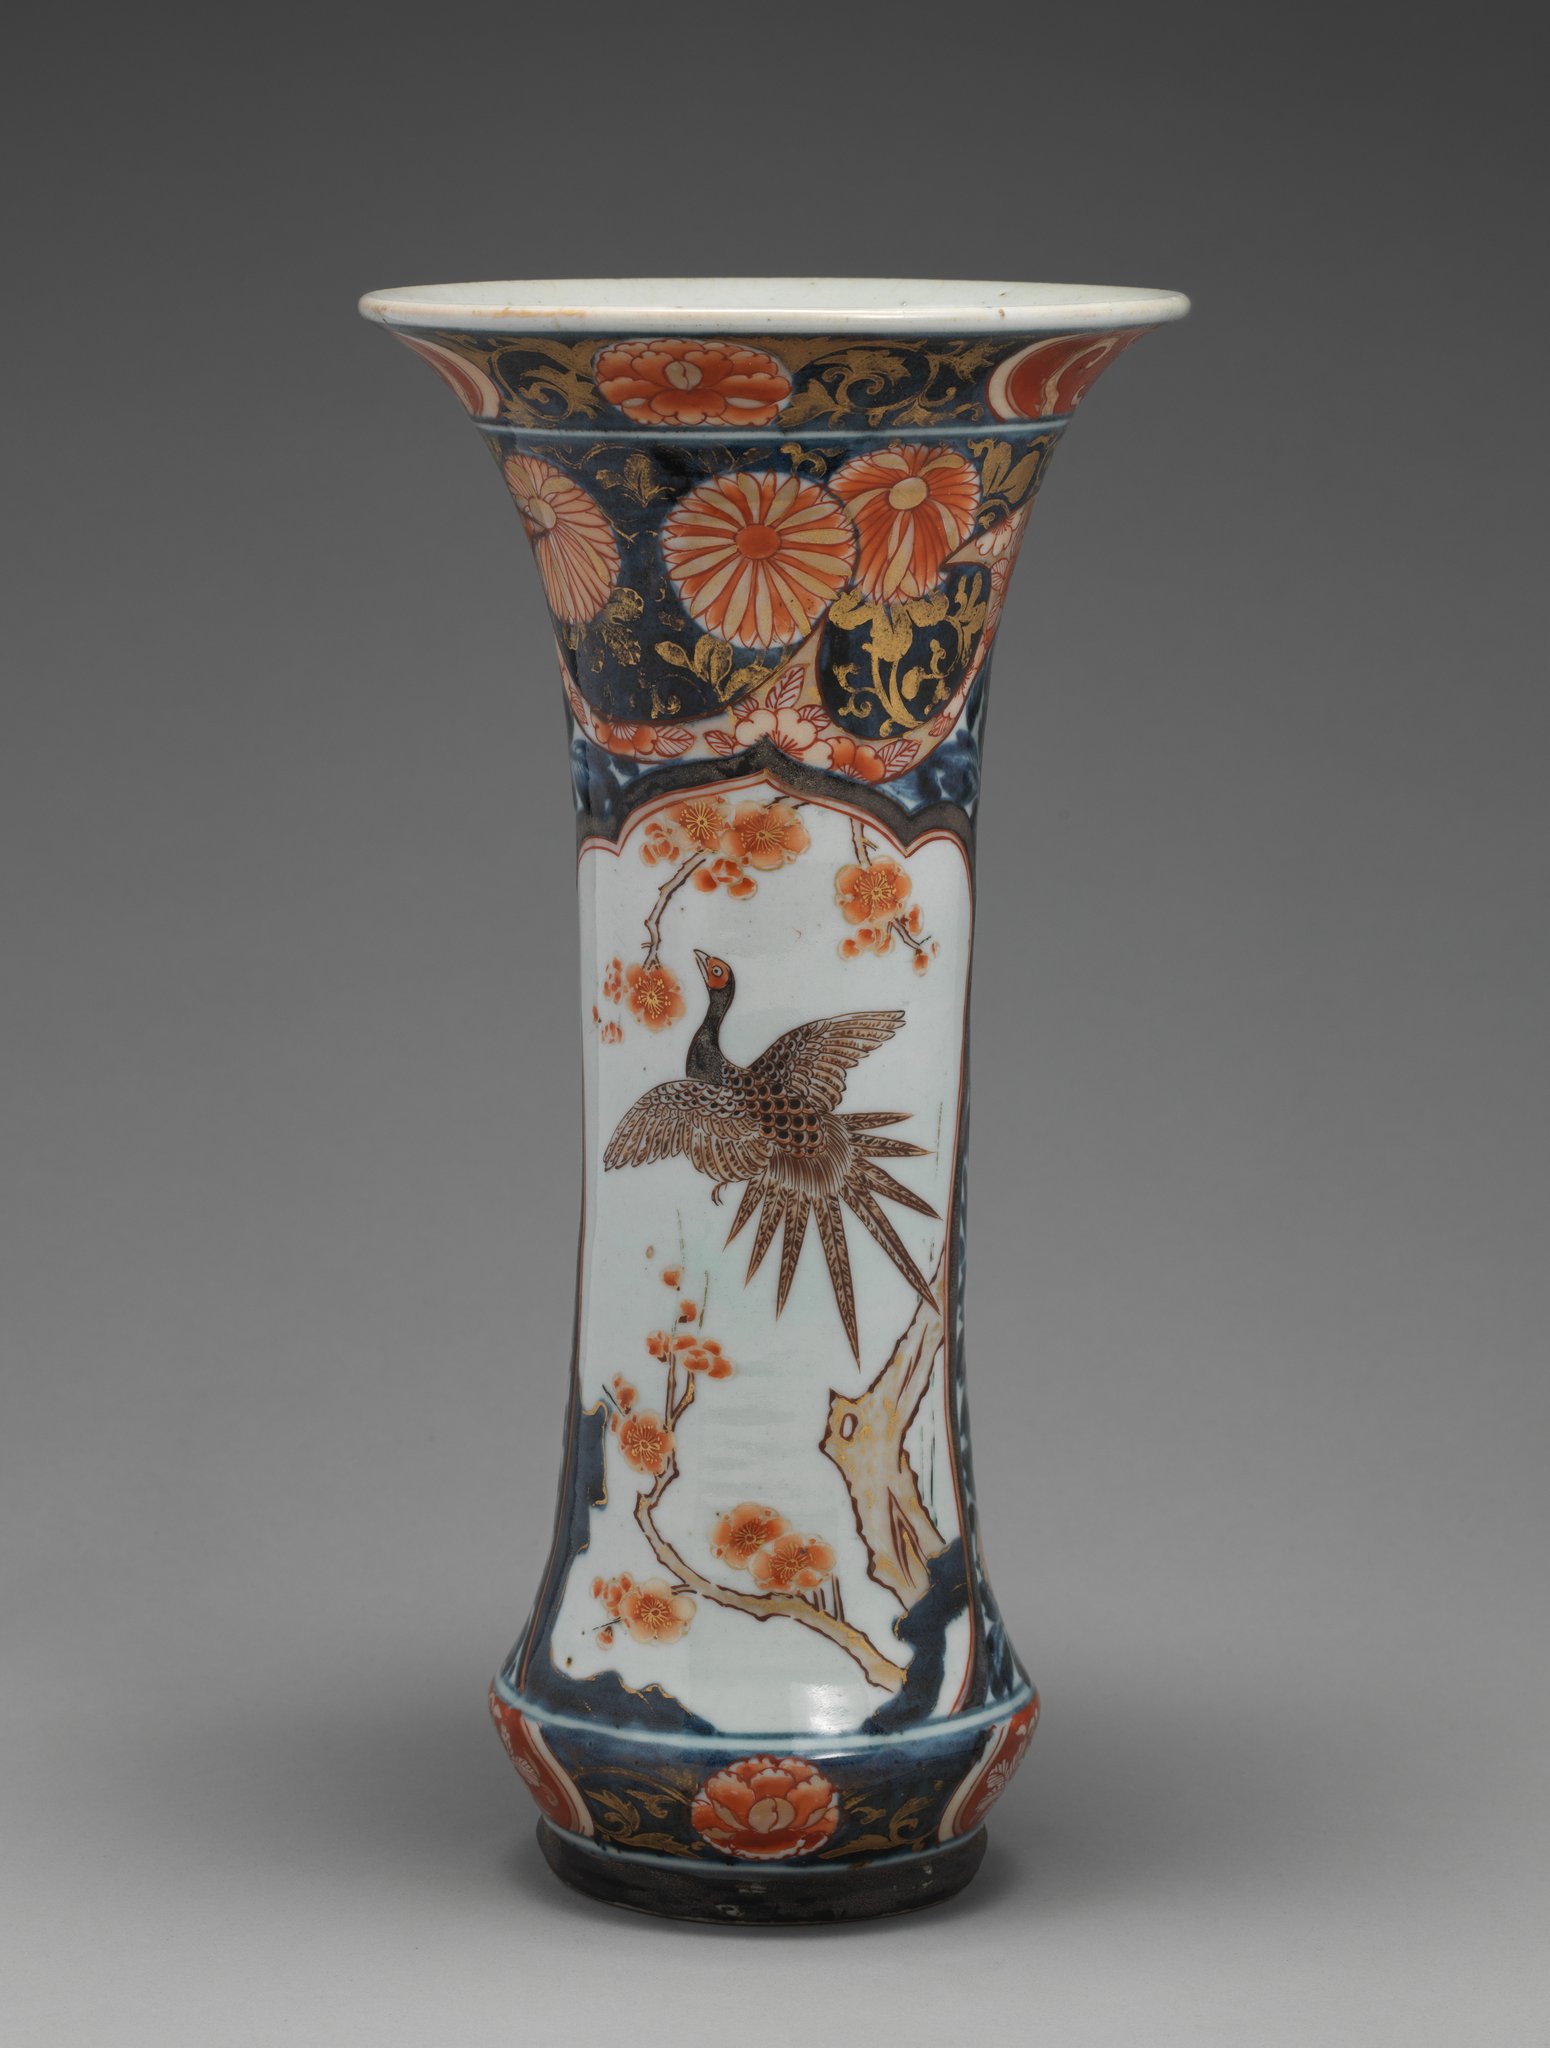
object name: vase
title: Beaker vase (part of a five-piece garniture)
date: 1690-1720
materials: enamel, hard paste porcelain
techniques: gilding, overglaze, underglaze